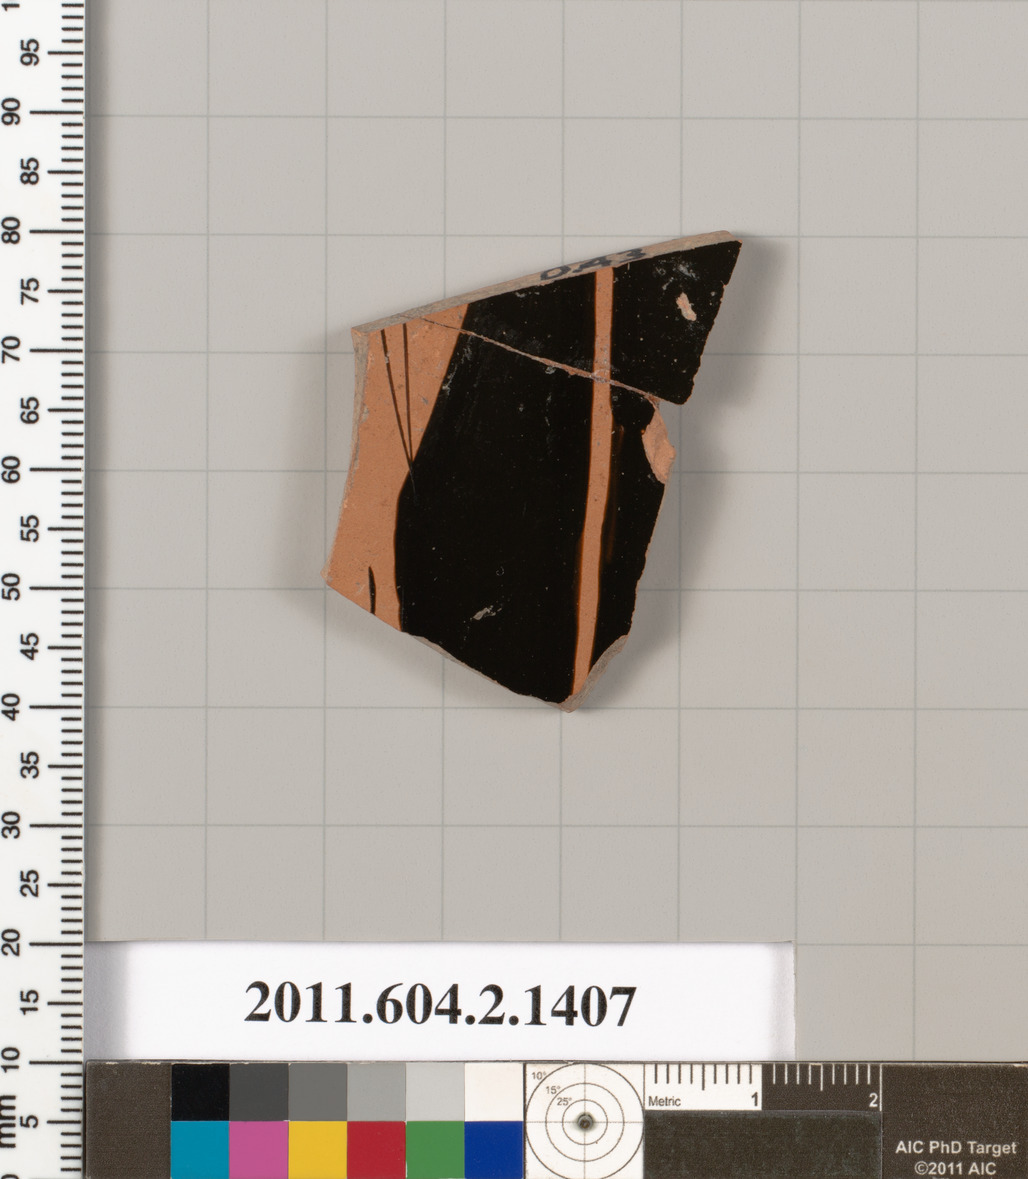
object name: skyphos fragment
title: Terracotta fragment of a skyphos (deep drinking cup)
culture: greek, attic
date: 467-435 BCE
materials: terracotta